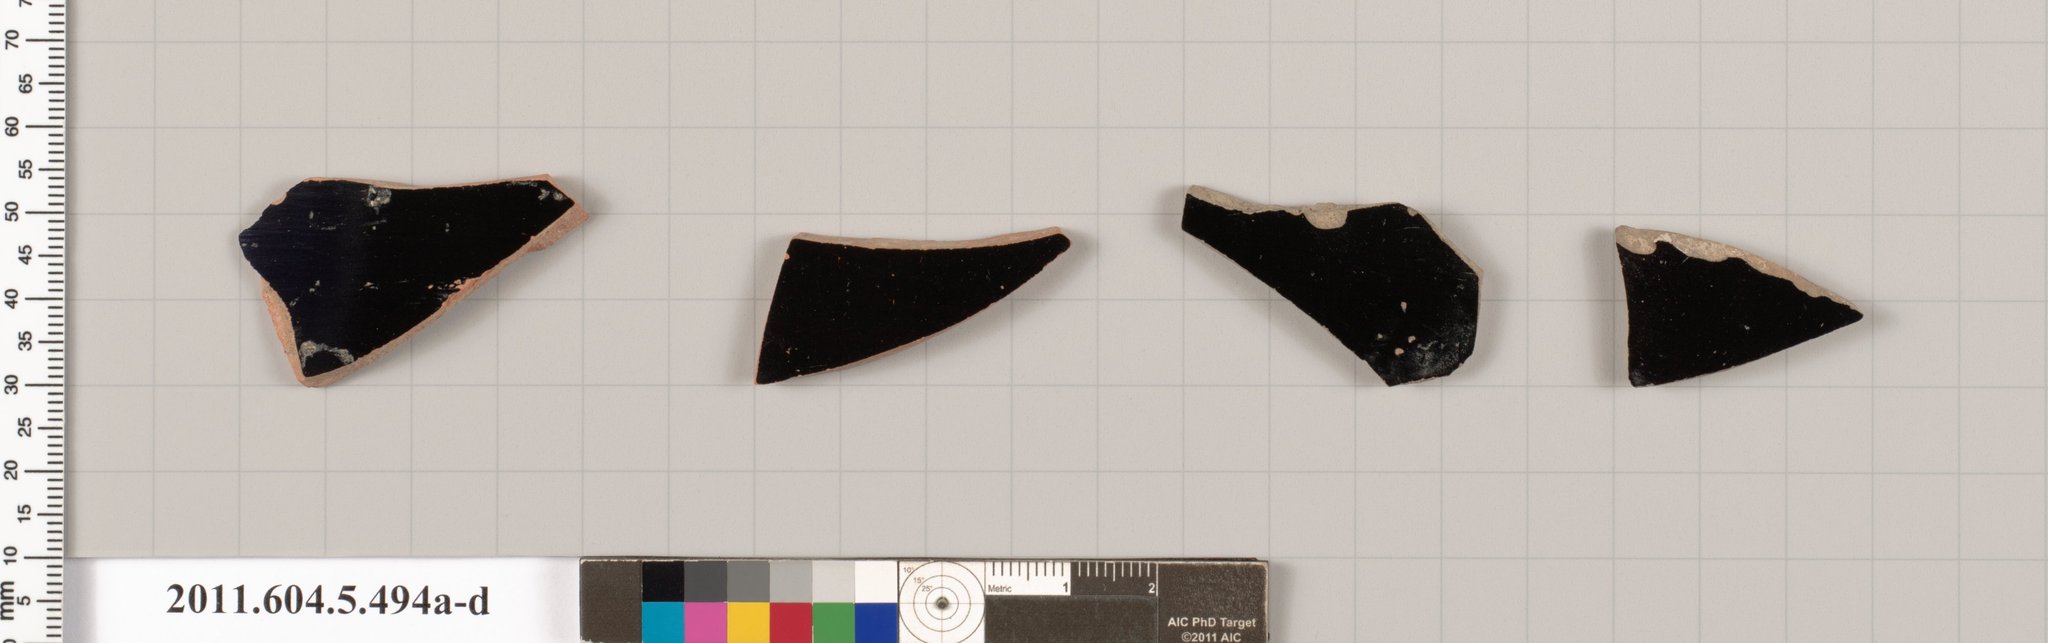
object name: kylix fragment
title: Terracotta fragments of kylikes (drinking cups)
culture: greek, attic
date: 600-401 BCE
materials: terracotta